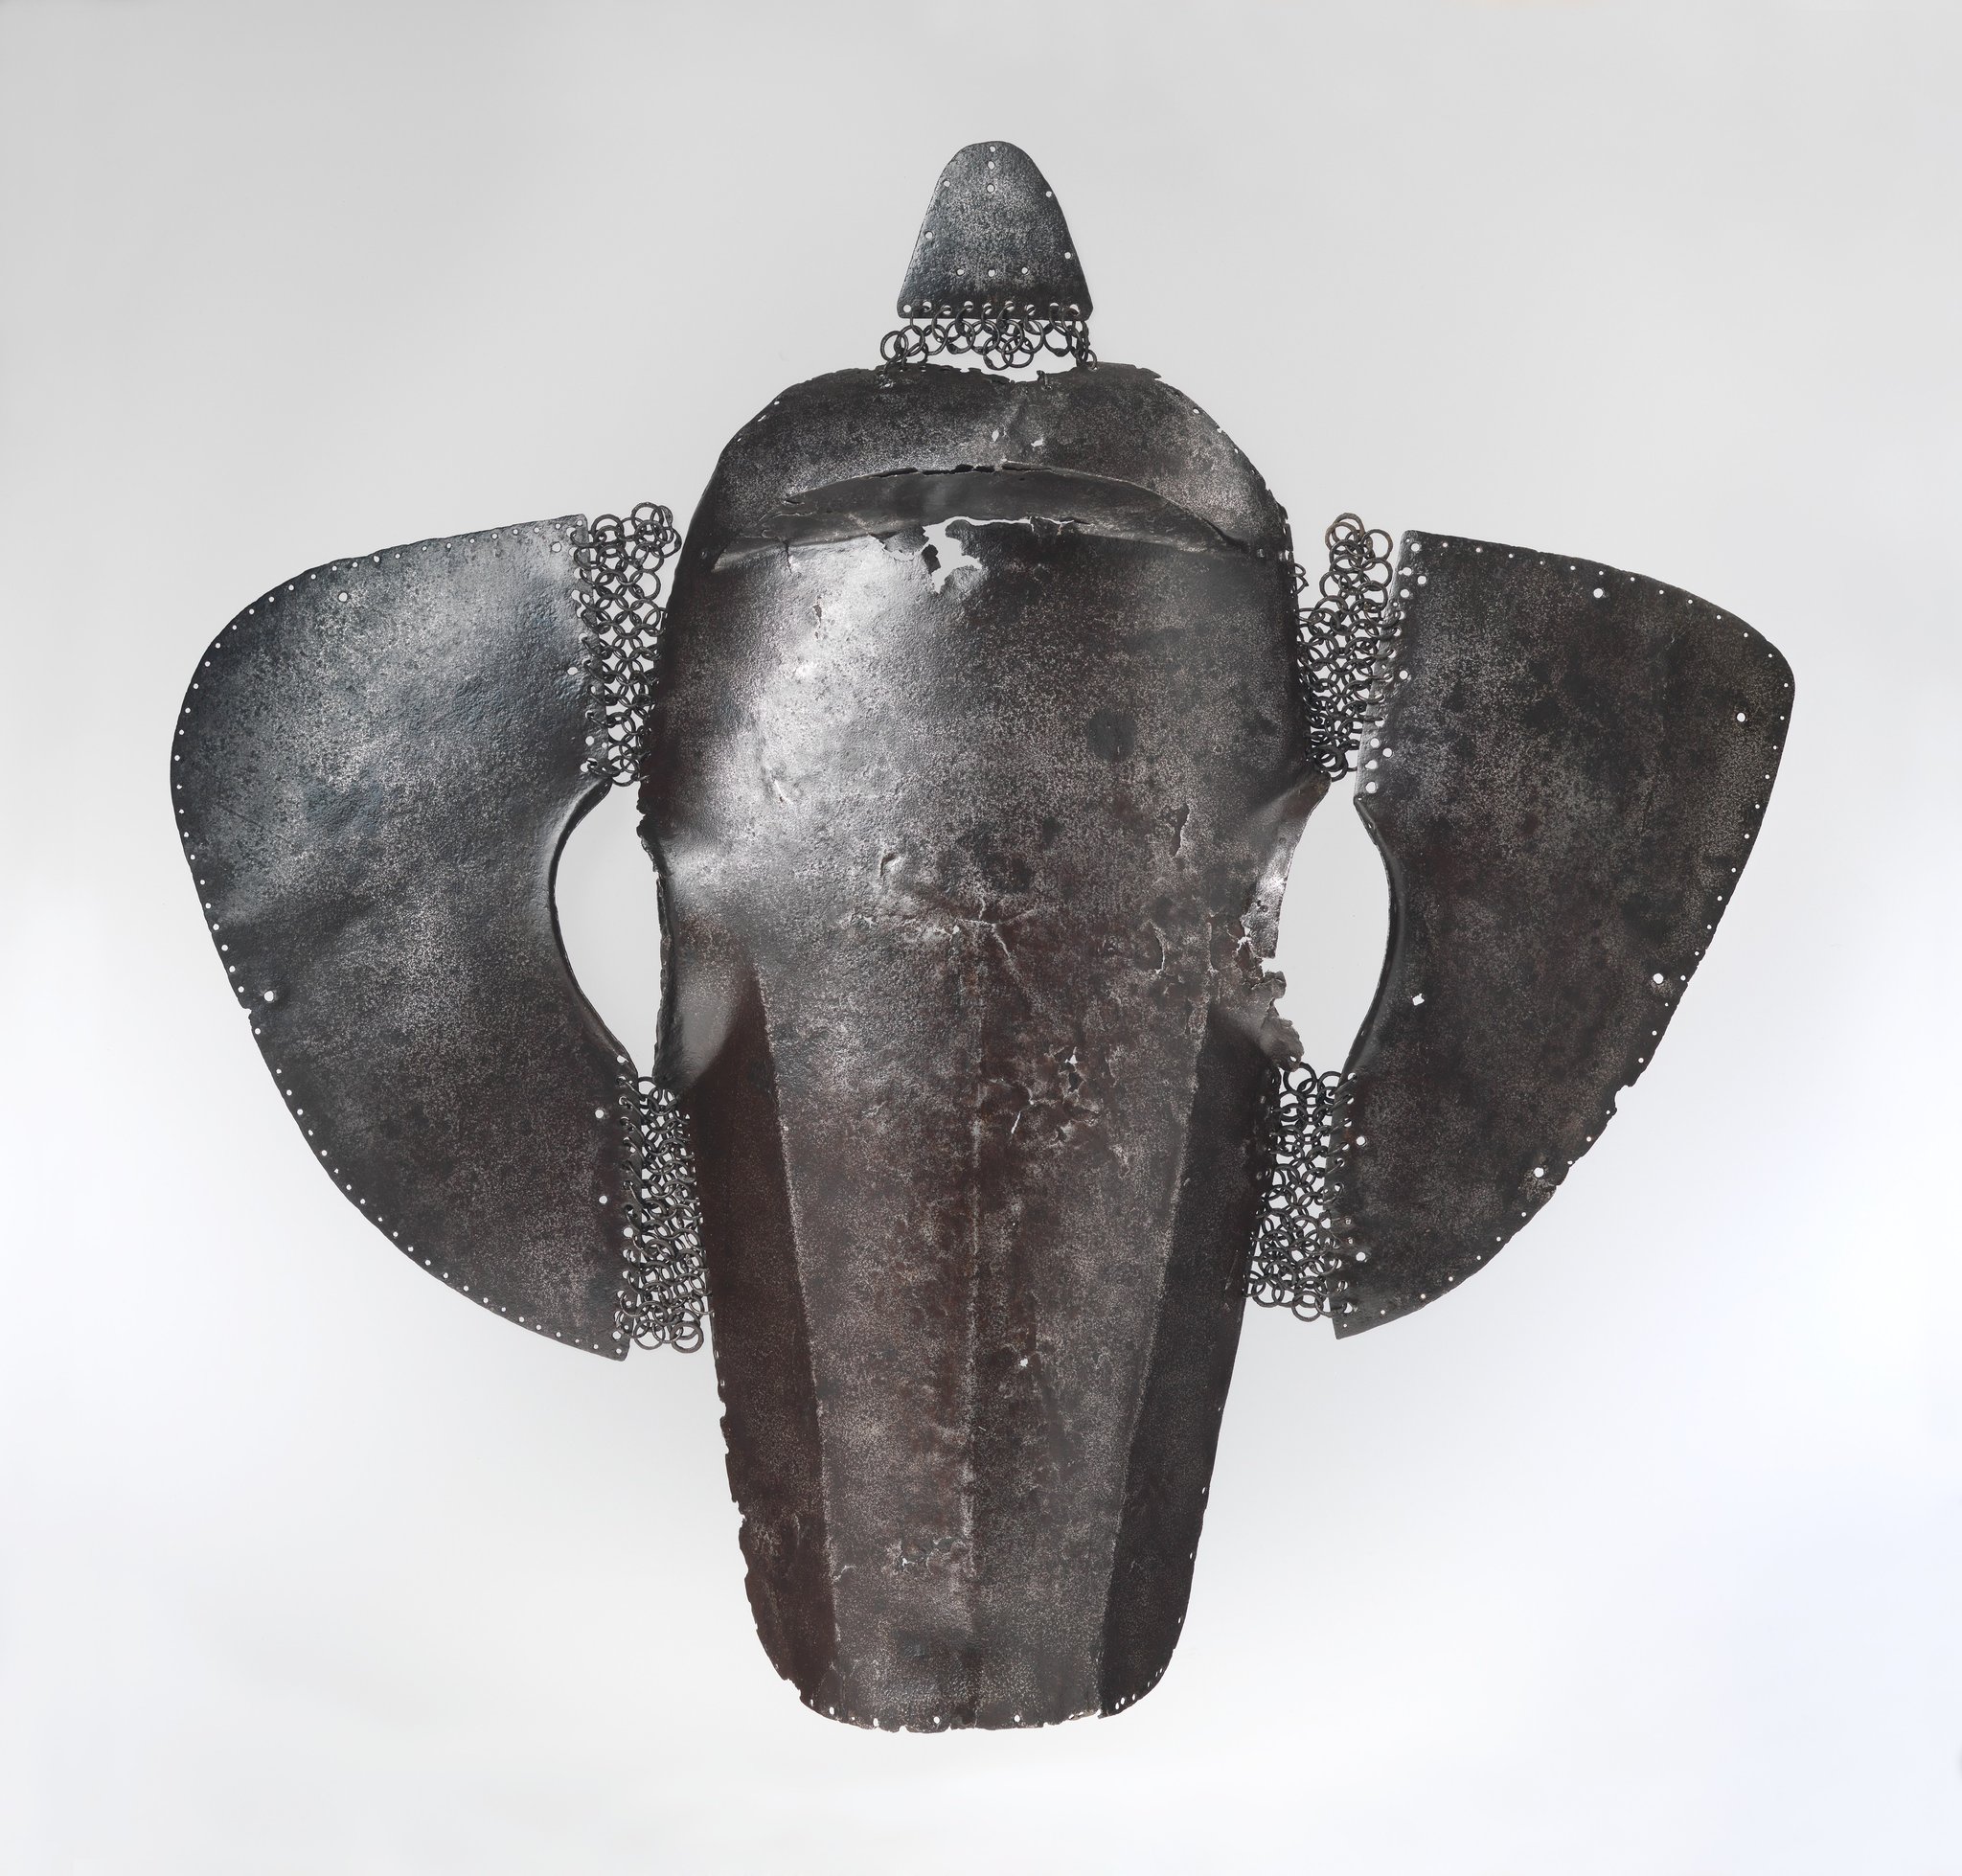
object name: shaffron horse's head defense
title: Shaffron (Horse's Head Defense)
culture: mamluk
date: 1401-1500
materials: steel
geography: ottoman empire